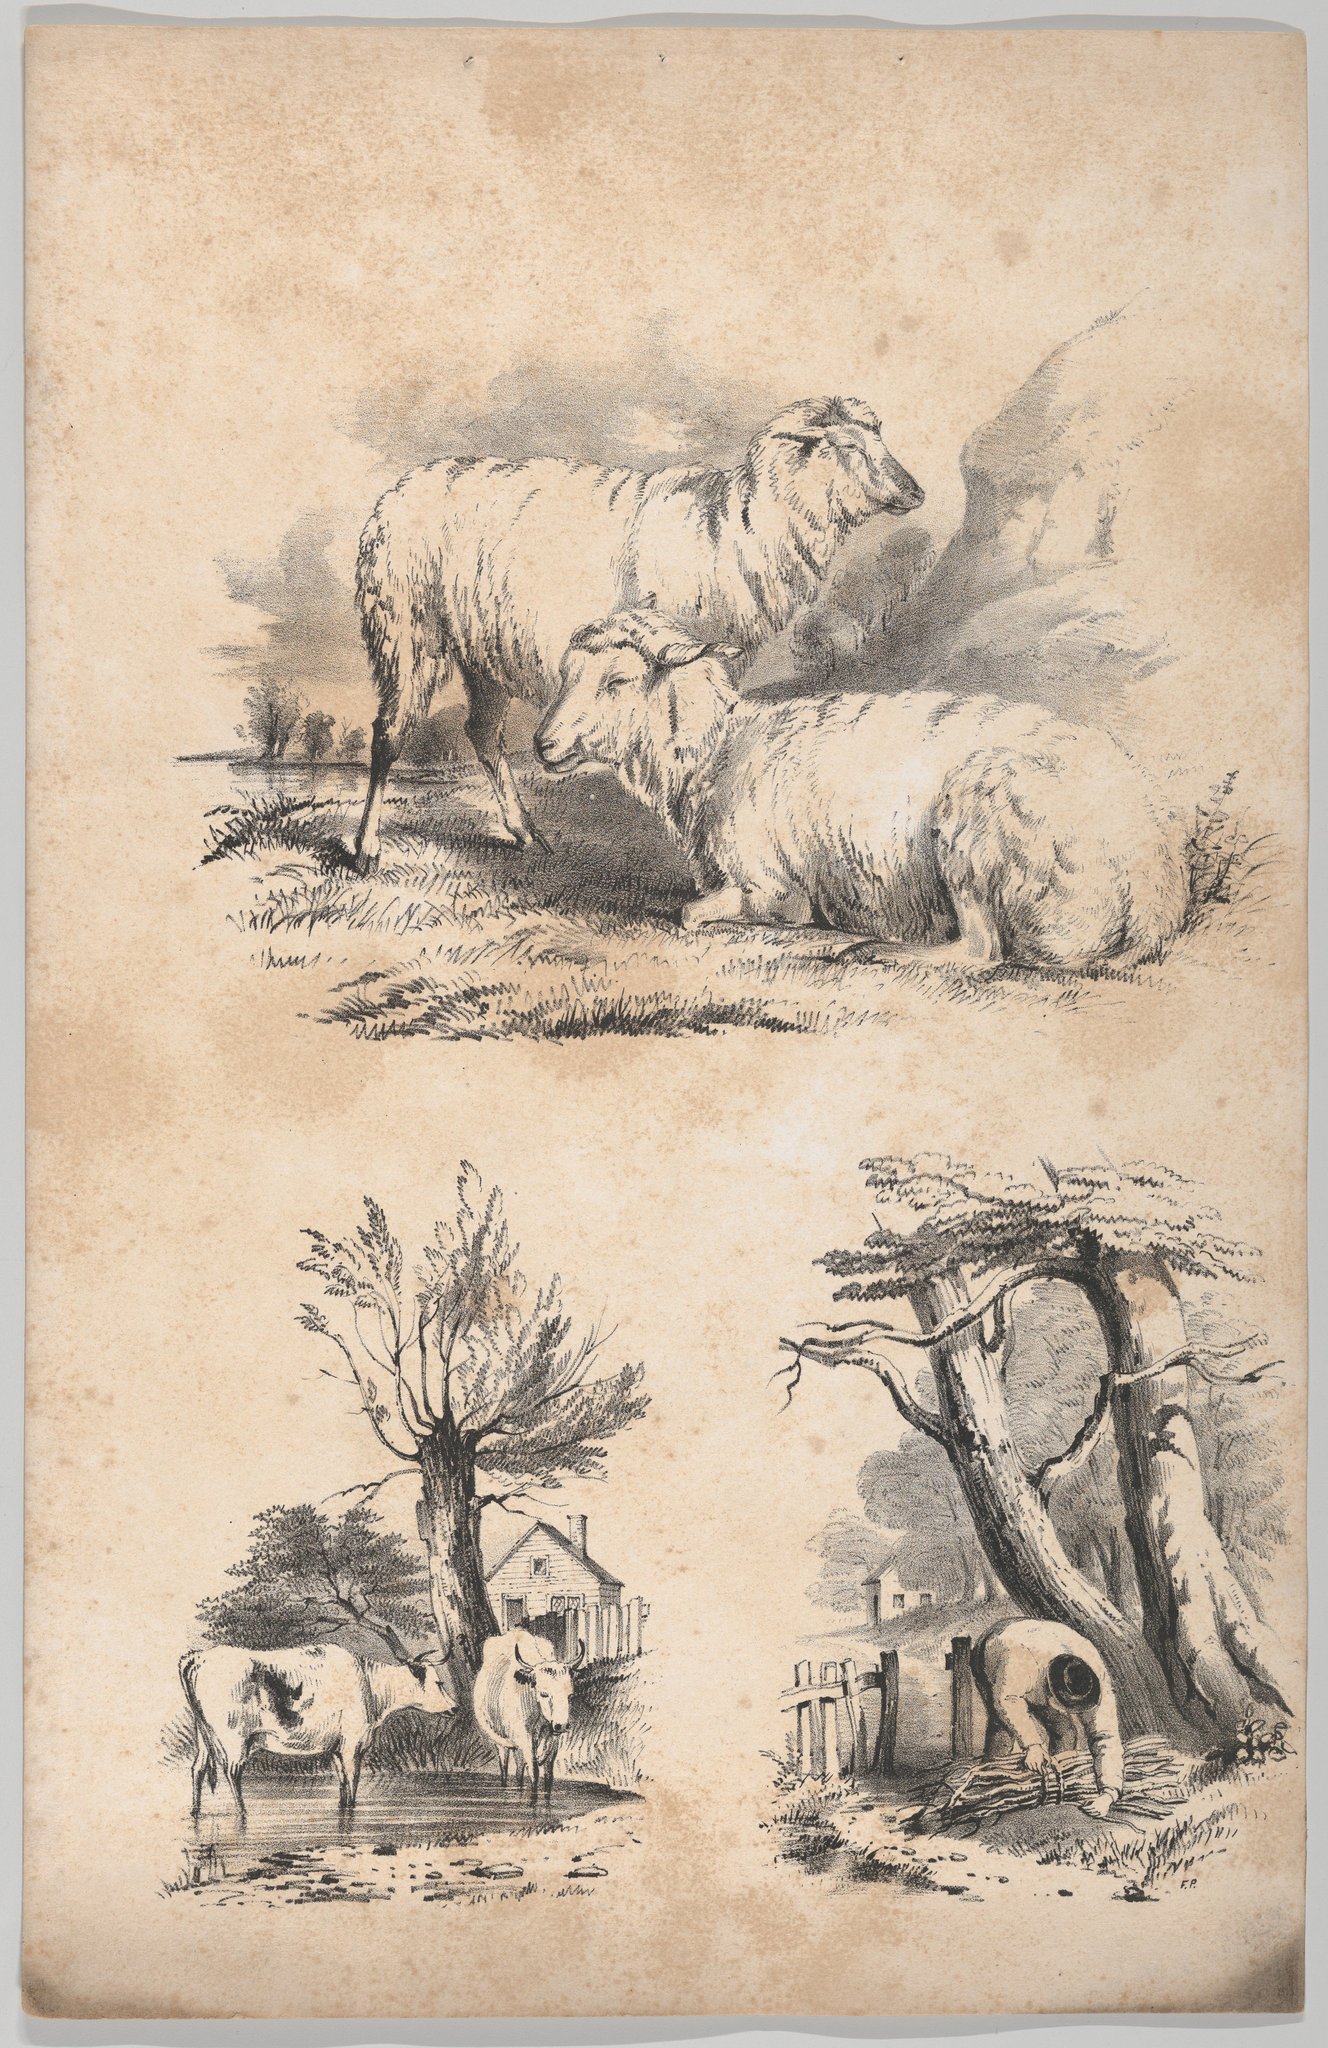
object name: book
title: Vignette with two sheep, Vignette with two cows in a pool, and Vignette of a wood-gatherer, in: The New York Drawing Book, Containing a Series of Original Designs and Sketches of American Scenery, No. 2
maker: frances flora bond palmer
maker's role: artist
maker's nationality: american, born england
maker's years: 1812-1876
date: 1847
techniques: lithograph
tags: men,cows,sheep,working